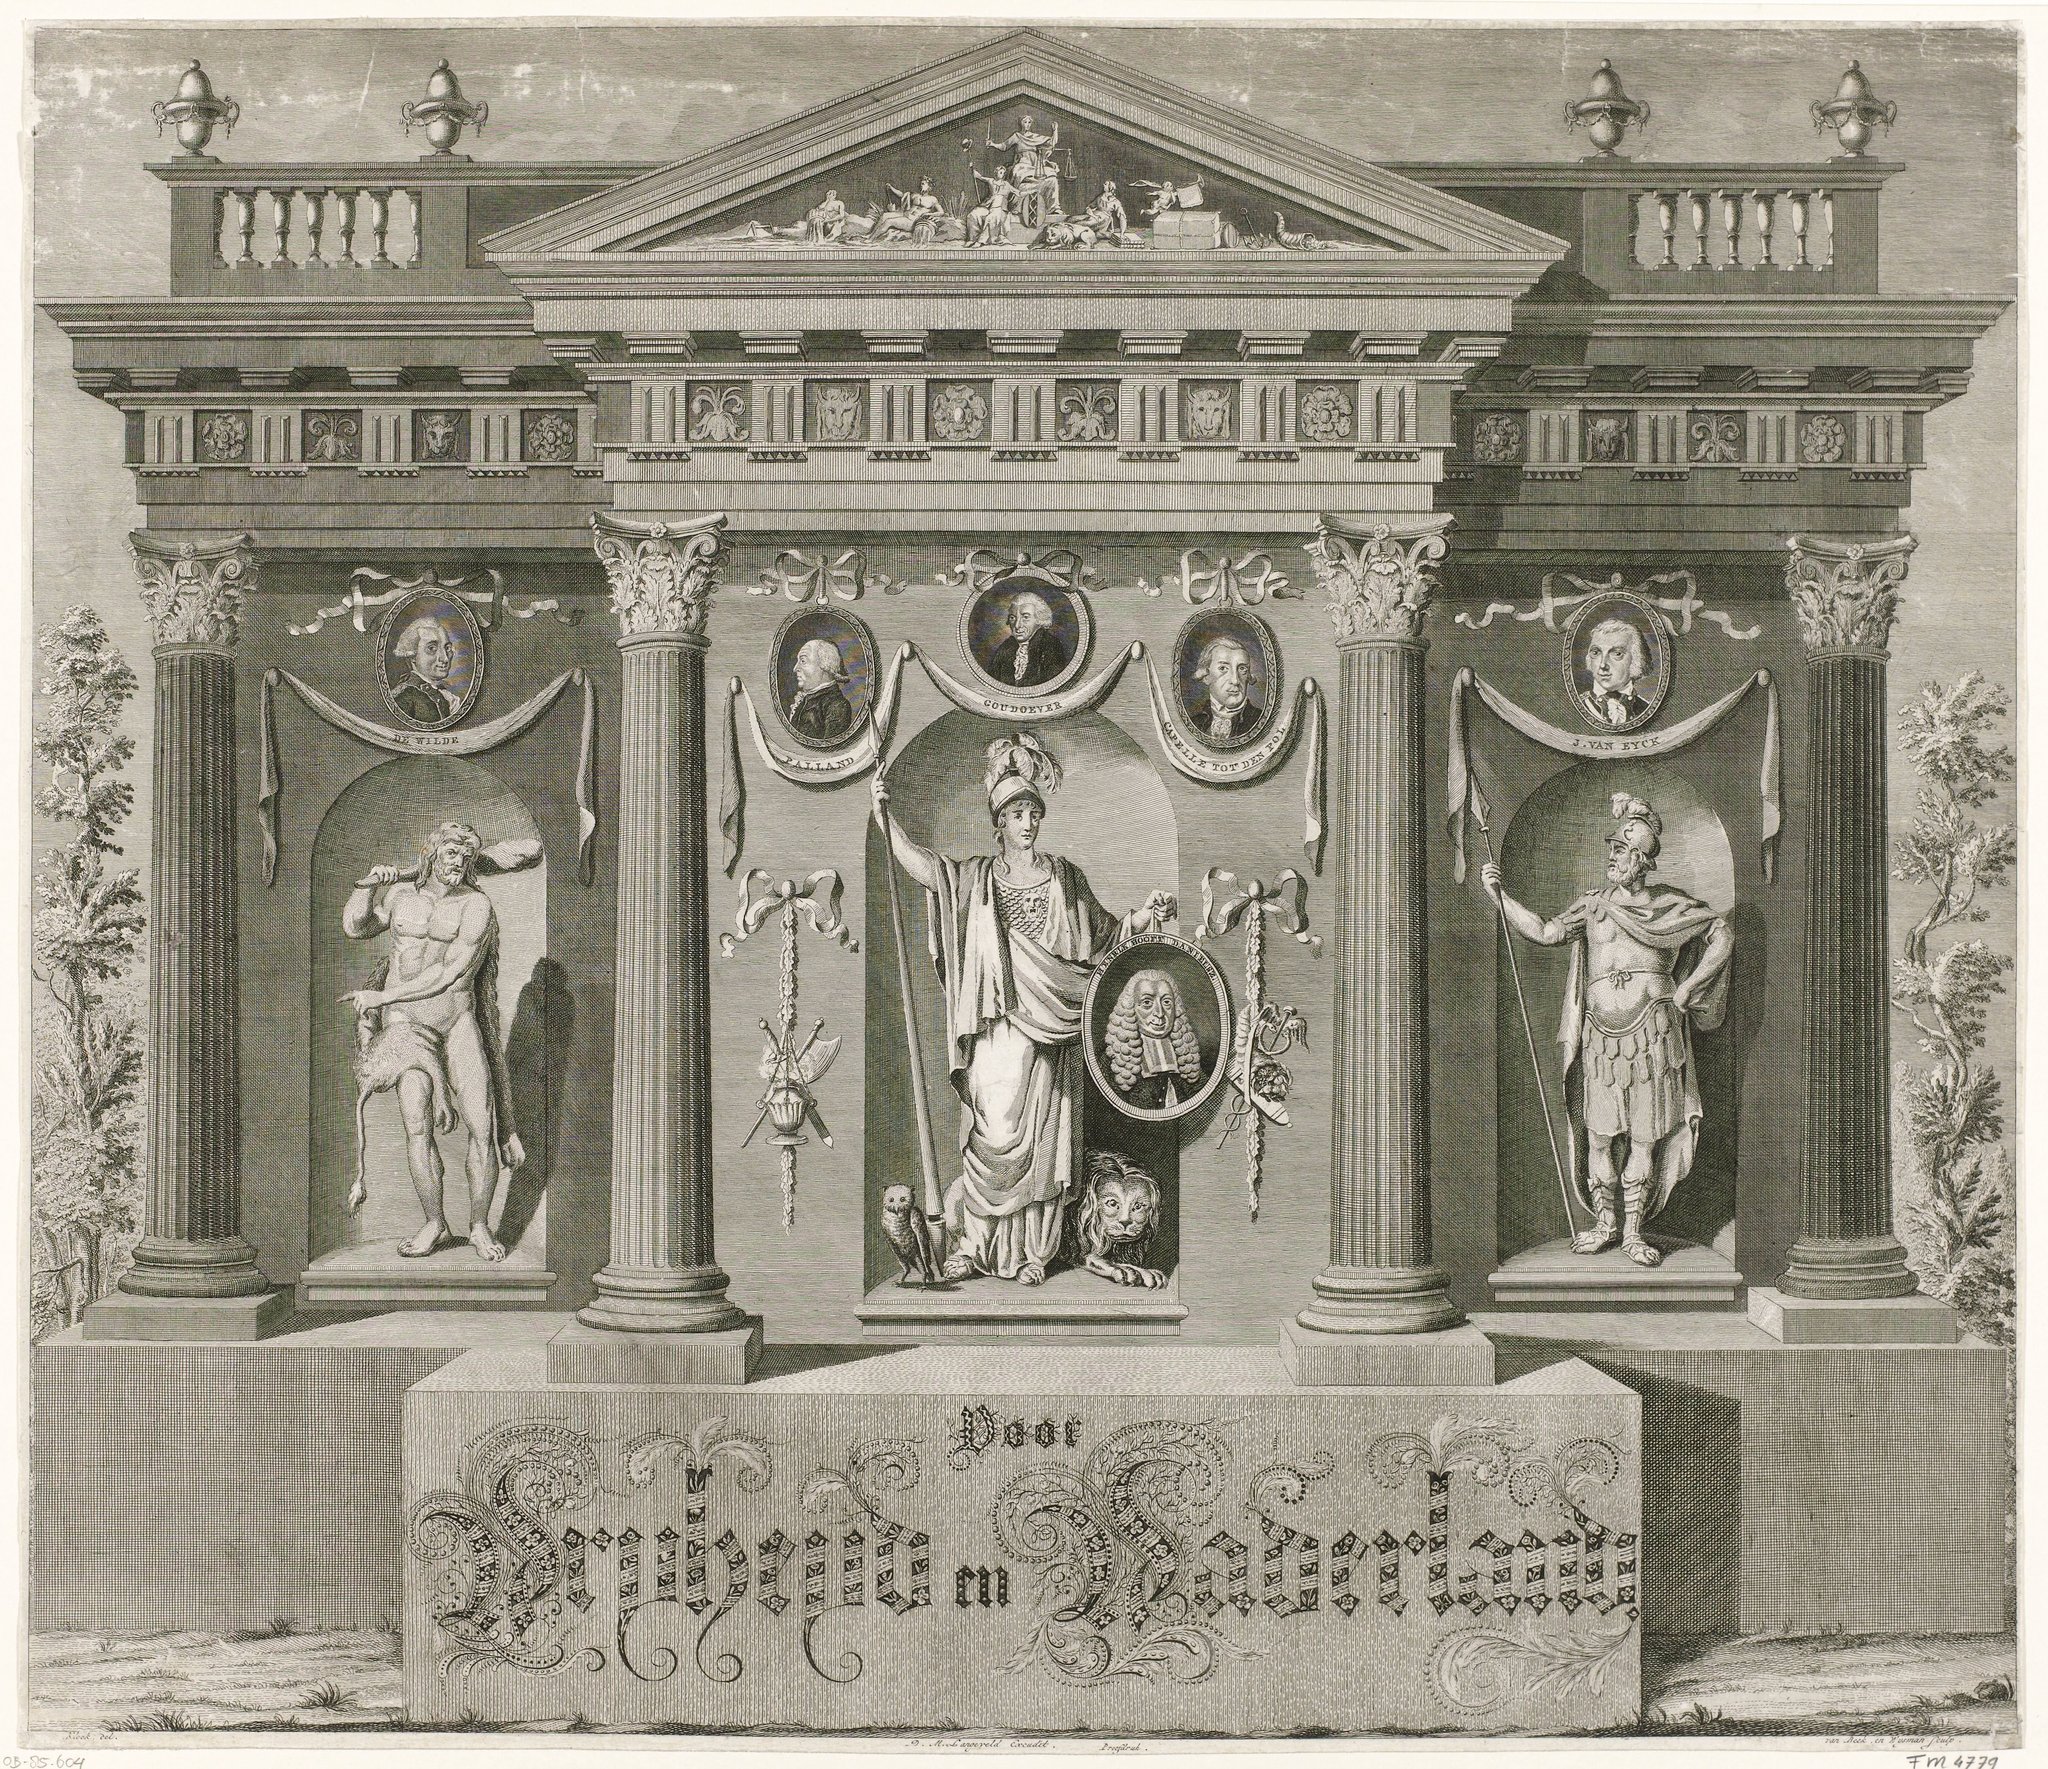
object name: print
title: Tempel ter ere van prominente patriotten als voorvechters van de vrijheid, 1787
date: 1787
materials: paper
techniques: engraving, etching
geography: northern netherlands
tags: hendrik danielsz. hooft, politician, joan derk van der capellen tot den pol, specific aspects, allegorical aspects of mars; mars as patron - veneration, honoured by, temple, shrine ~ roman religion, calligraphy, specific aspects, allegorical aspects of minerva; minerva as patroness, specific aspects, allegorical aspects of hercules; hercules as patron, patriots (1780-1795)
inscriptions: collector's mark: Lugt 2228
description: Allegorie van ca. 1787 met een portiek van een tempel waarin portretten hangen van prominente patriotten als voorvechters van de vrijheid: Hendrik Danielsz. Hooft, George Hendrik de Wilde, baron van Pallandt, Isaac van Goudoever, Joan Derk van der Capellen tot den Pol en M.J. Eyck. Links een standbeeld van Hercules, in het midden Minerva als de Vrijheid en rechts Mars. Bovenaan in het pediment een beeldengroep met het stadswapen van Amsterdam. Onderaan de titel in kalligrafie.